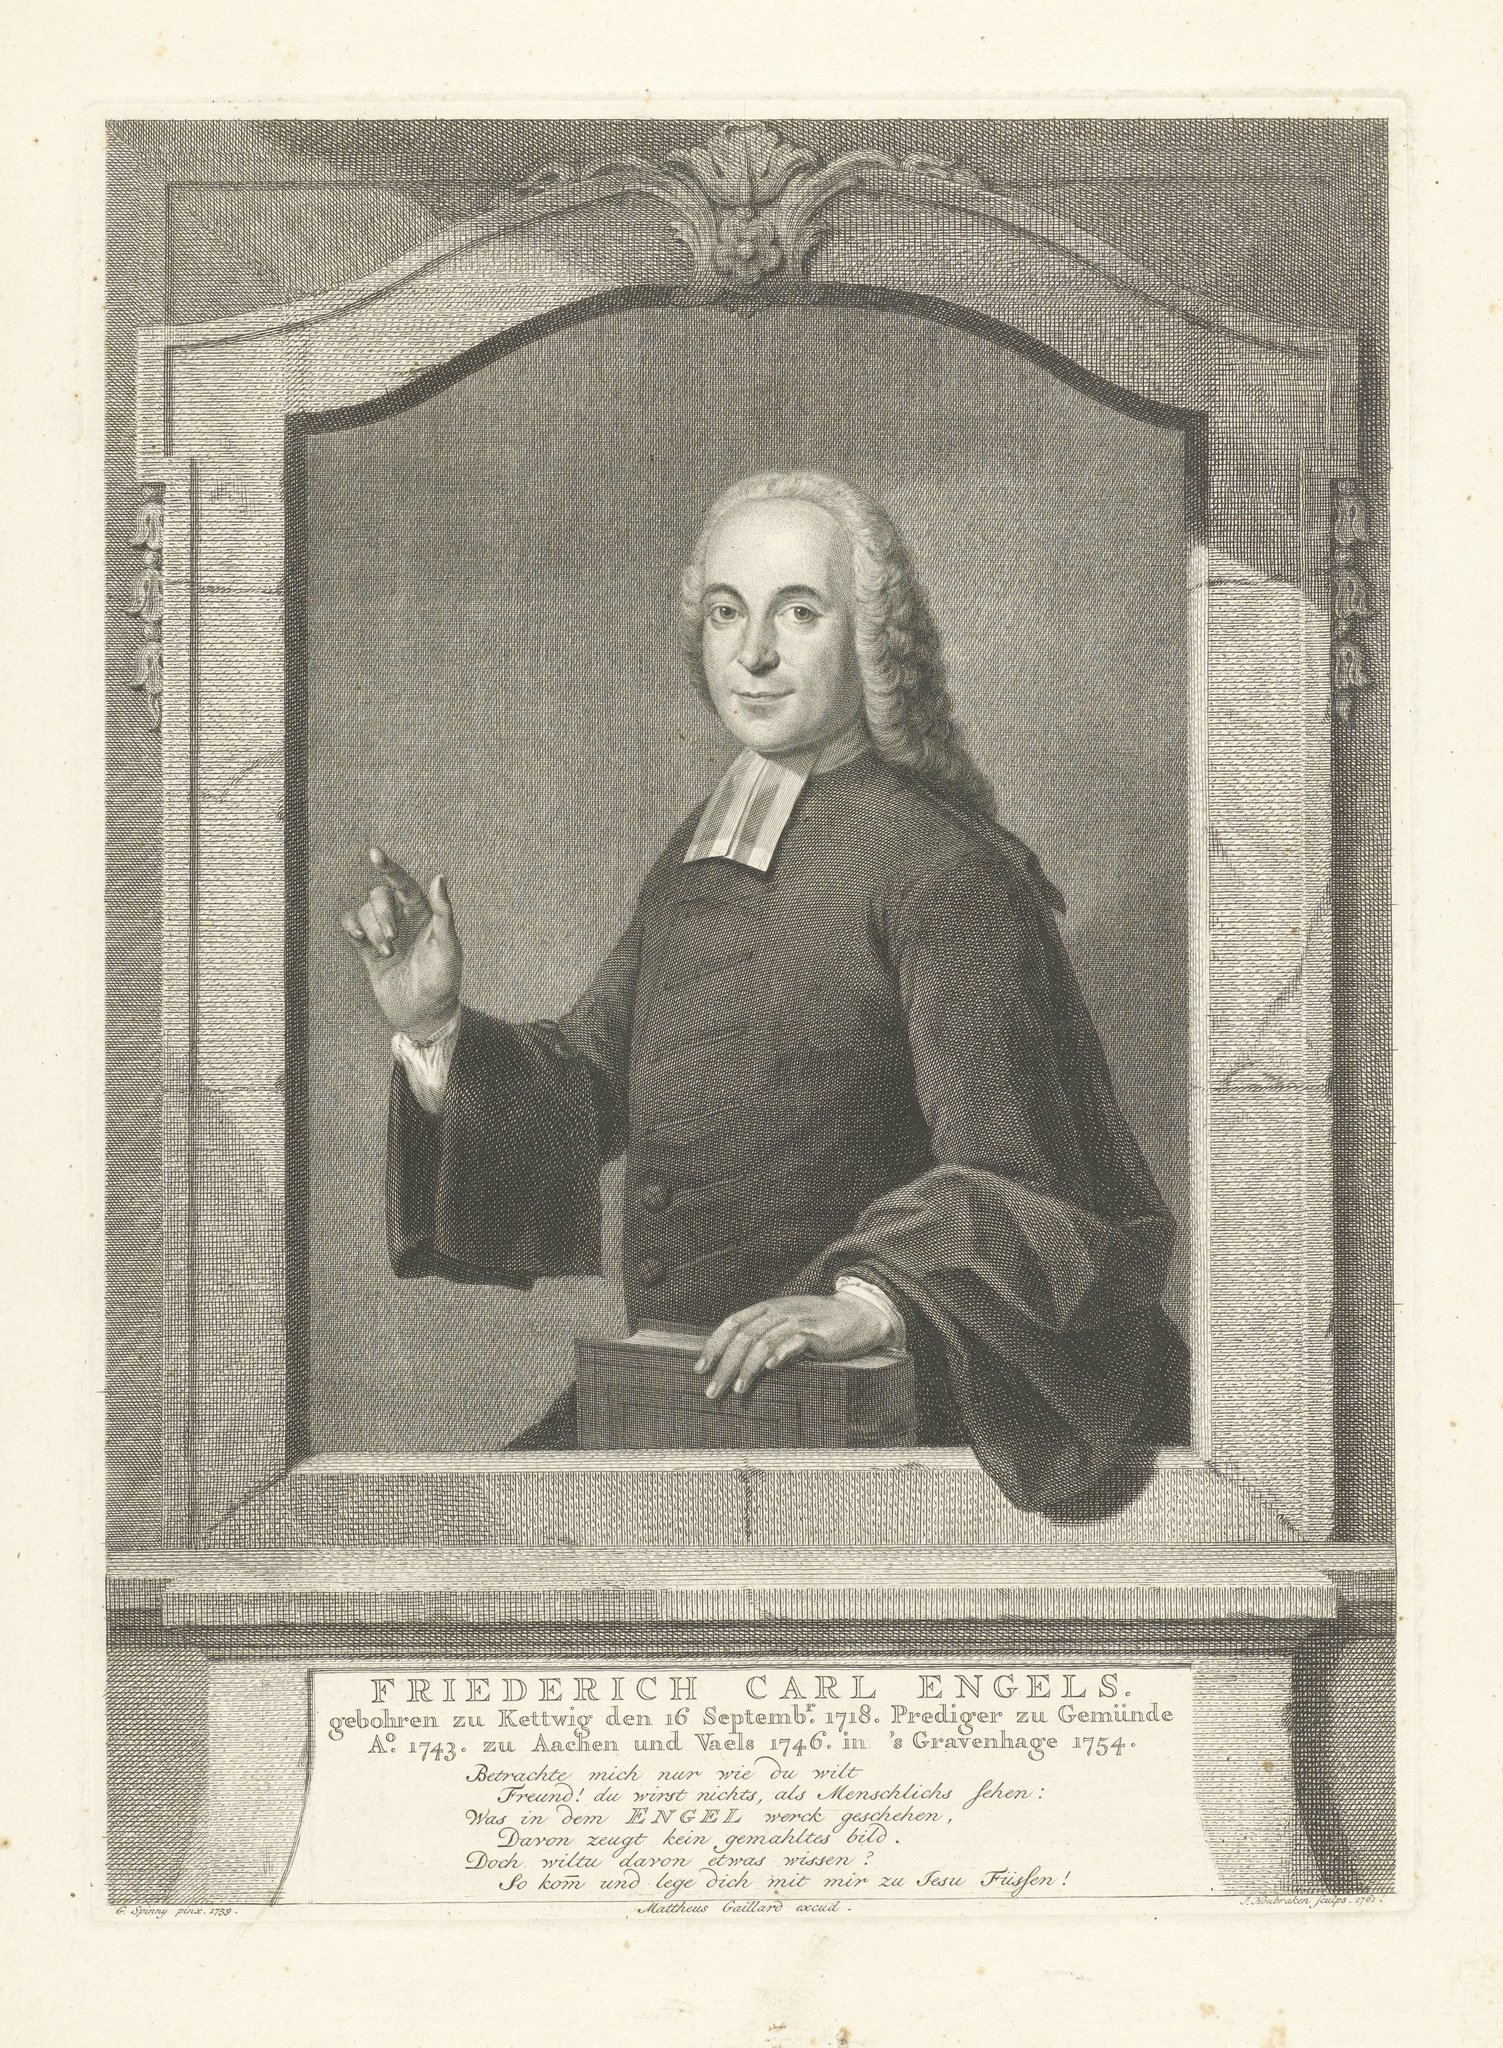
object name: print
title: Portret van Friederich Carl Engels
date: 1761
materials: paper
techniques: engraving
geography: amsterdam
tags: predikant, frederik carel engels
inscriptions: collector's mark: Lugt 2228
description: Friederich Carl Engels op 41-jarige leeftijd, ten halven lijve in een architectonische toogvormig venster. Zijn linkerhand rust op een bijbel. Onder het portret een plint waarop zijn naam en gegevens in drie regels in het Duits, daaronder een zesregelig vers in het Duits.